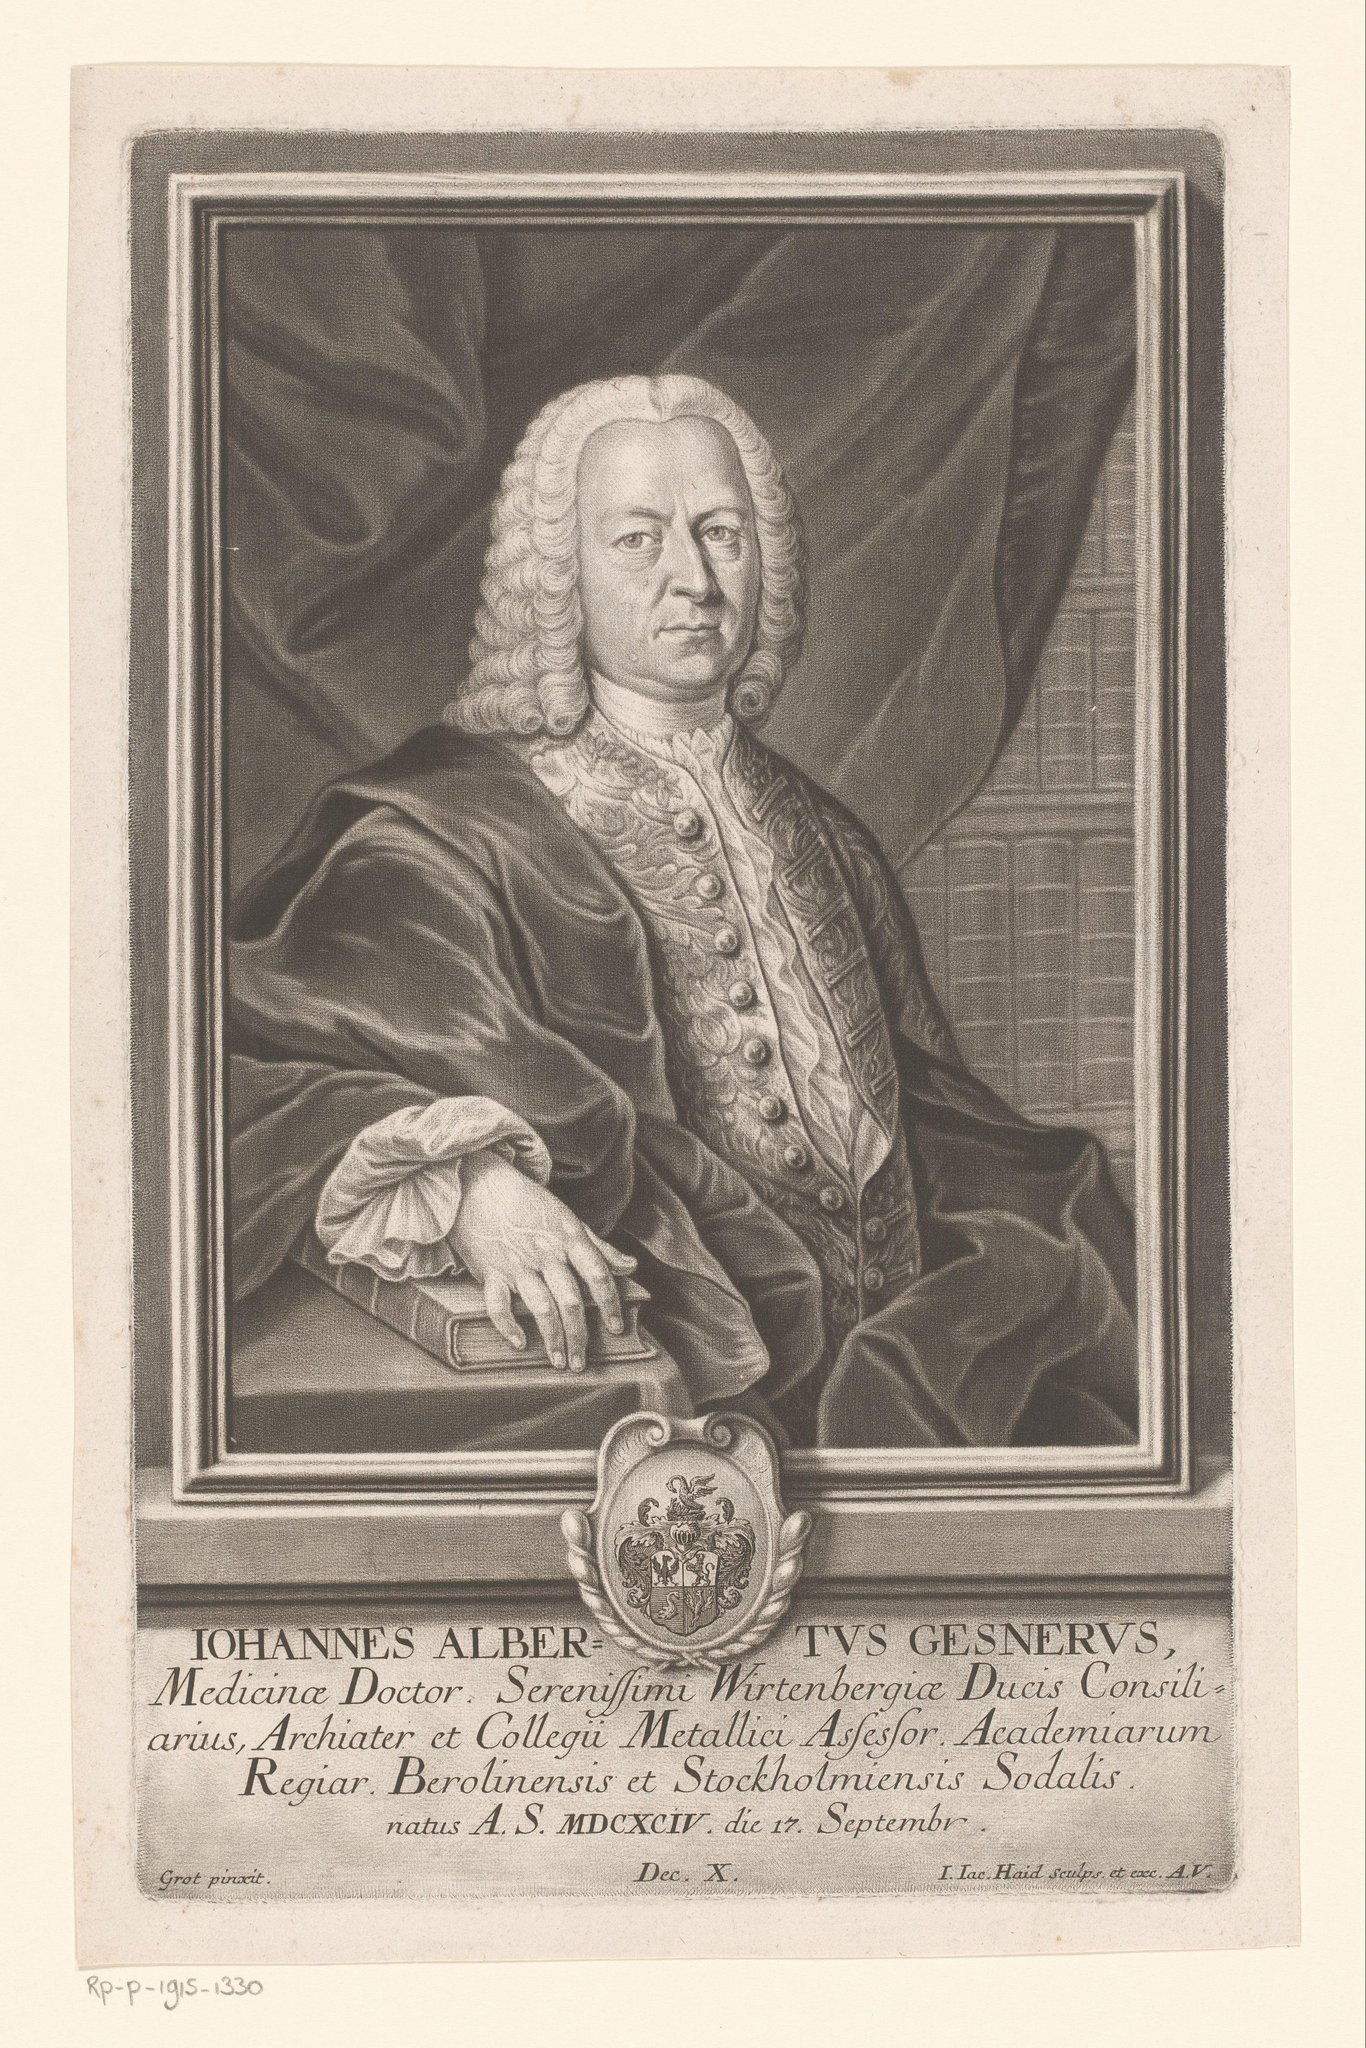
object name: print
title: Portret van Johann Albrecht Gesner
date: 1755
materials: paper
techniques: etching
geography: augsburg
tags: bookshelves, historical persons, armorial bearing, heraldry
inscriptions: collector's mark: Lugt 2228